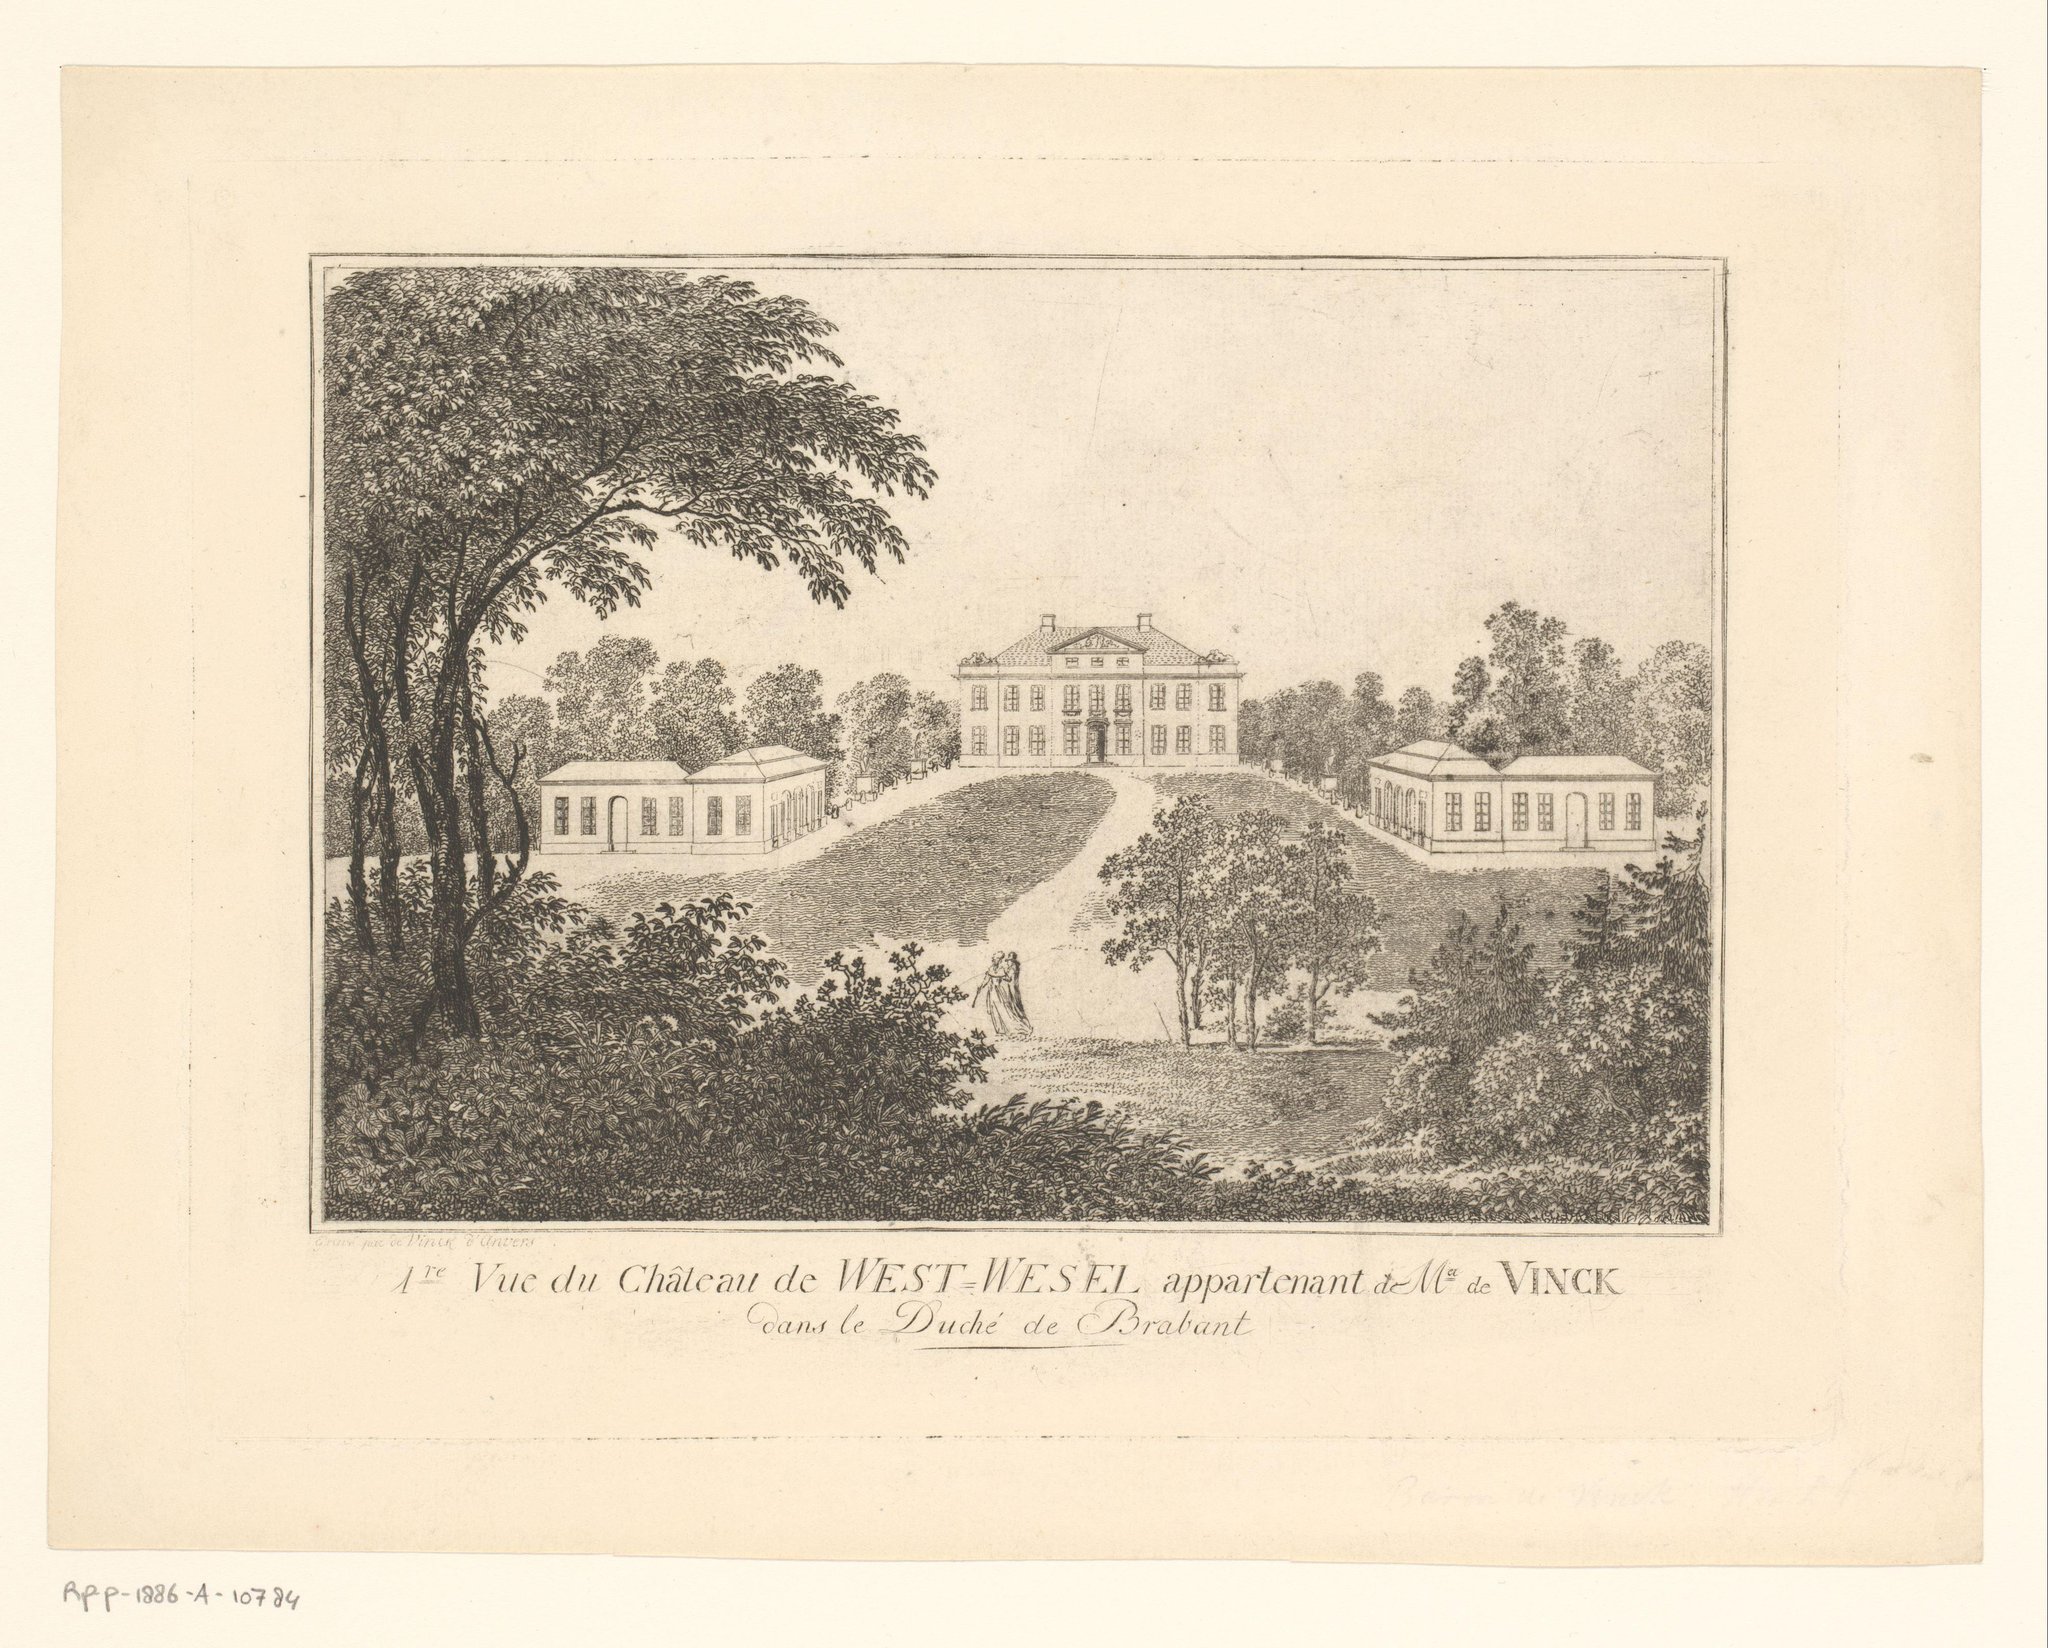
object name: print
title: Gezicht op het kasteel Ginhoven te Wuustwezel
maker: de vinck (baron)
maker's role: print maker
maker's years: 1808-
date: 1825-1874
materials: paper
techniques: etching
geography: antwerp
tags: civic architecture; edifices; dwellings, brabant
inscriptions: collector's mark: Lugt 2228